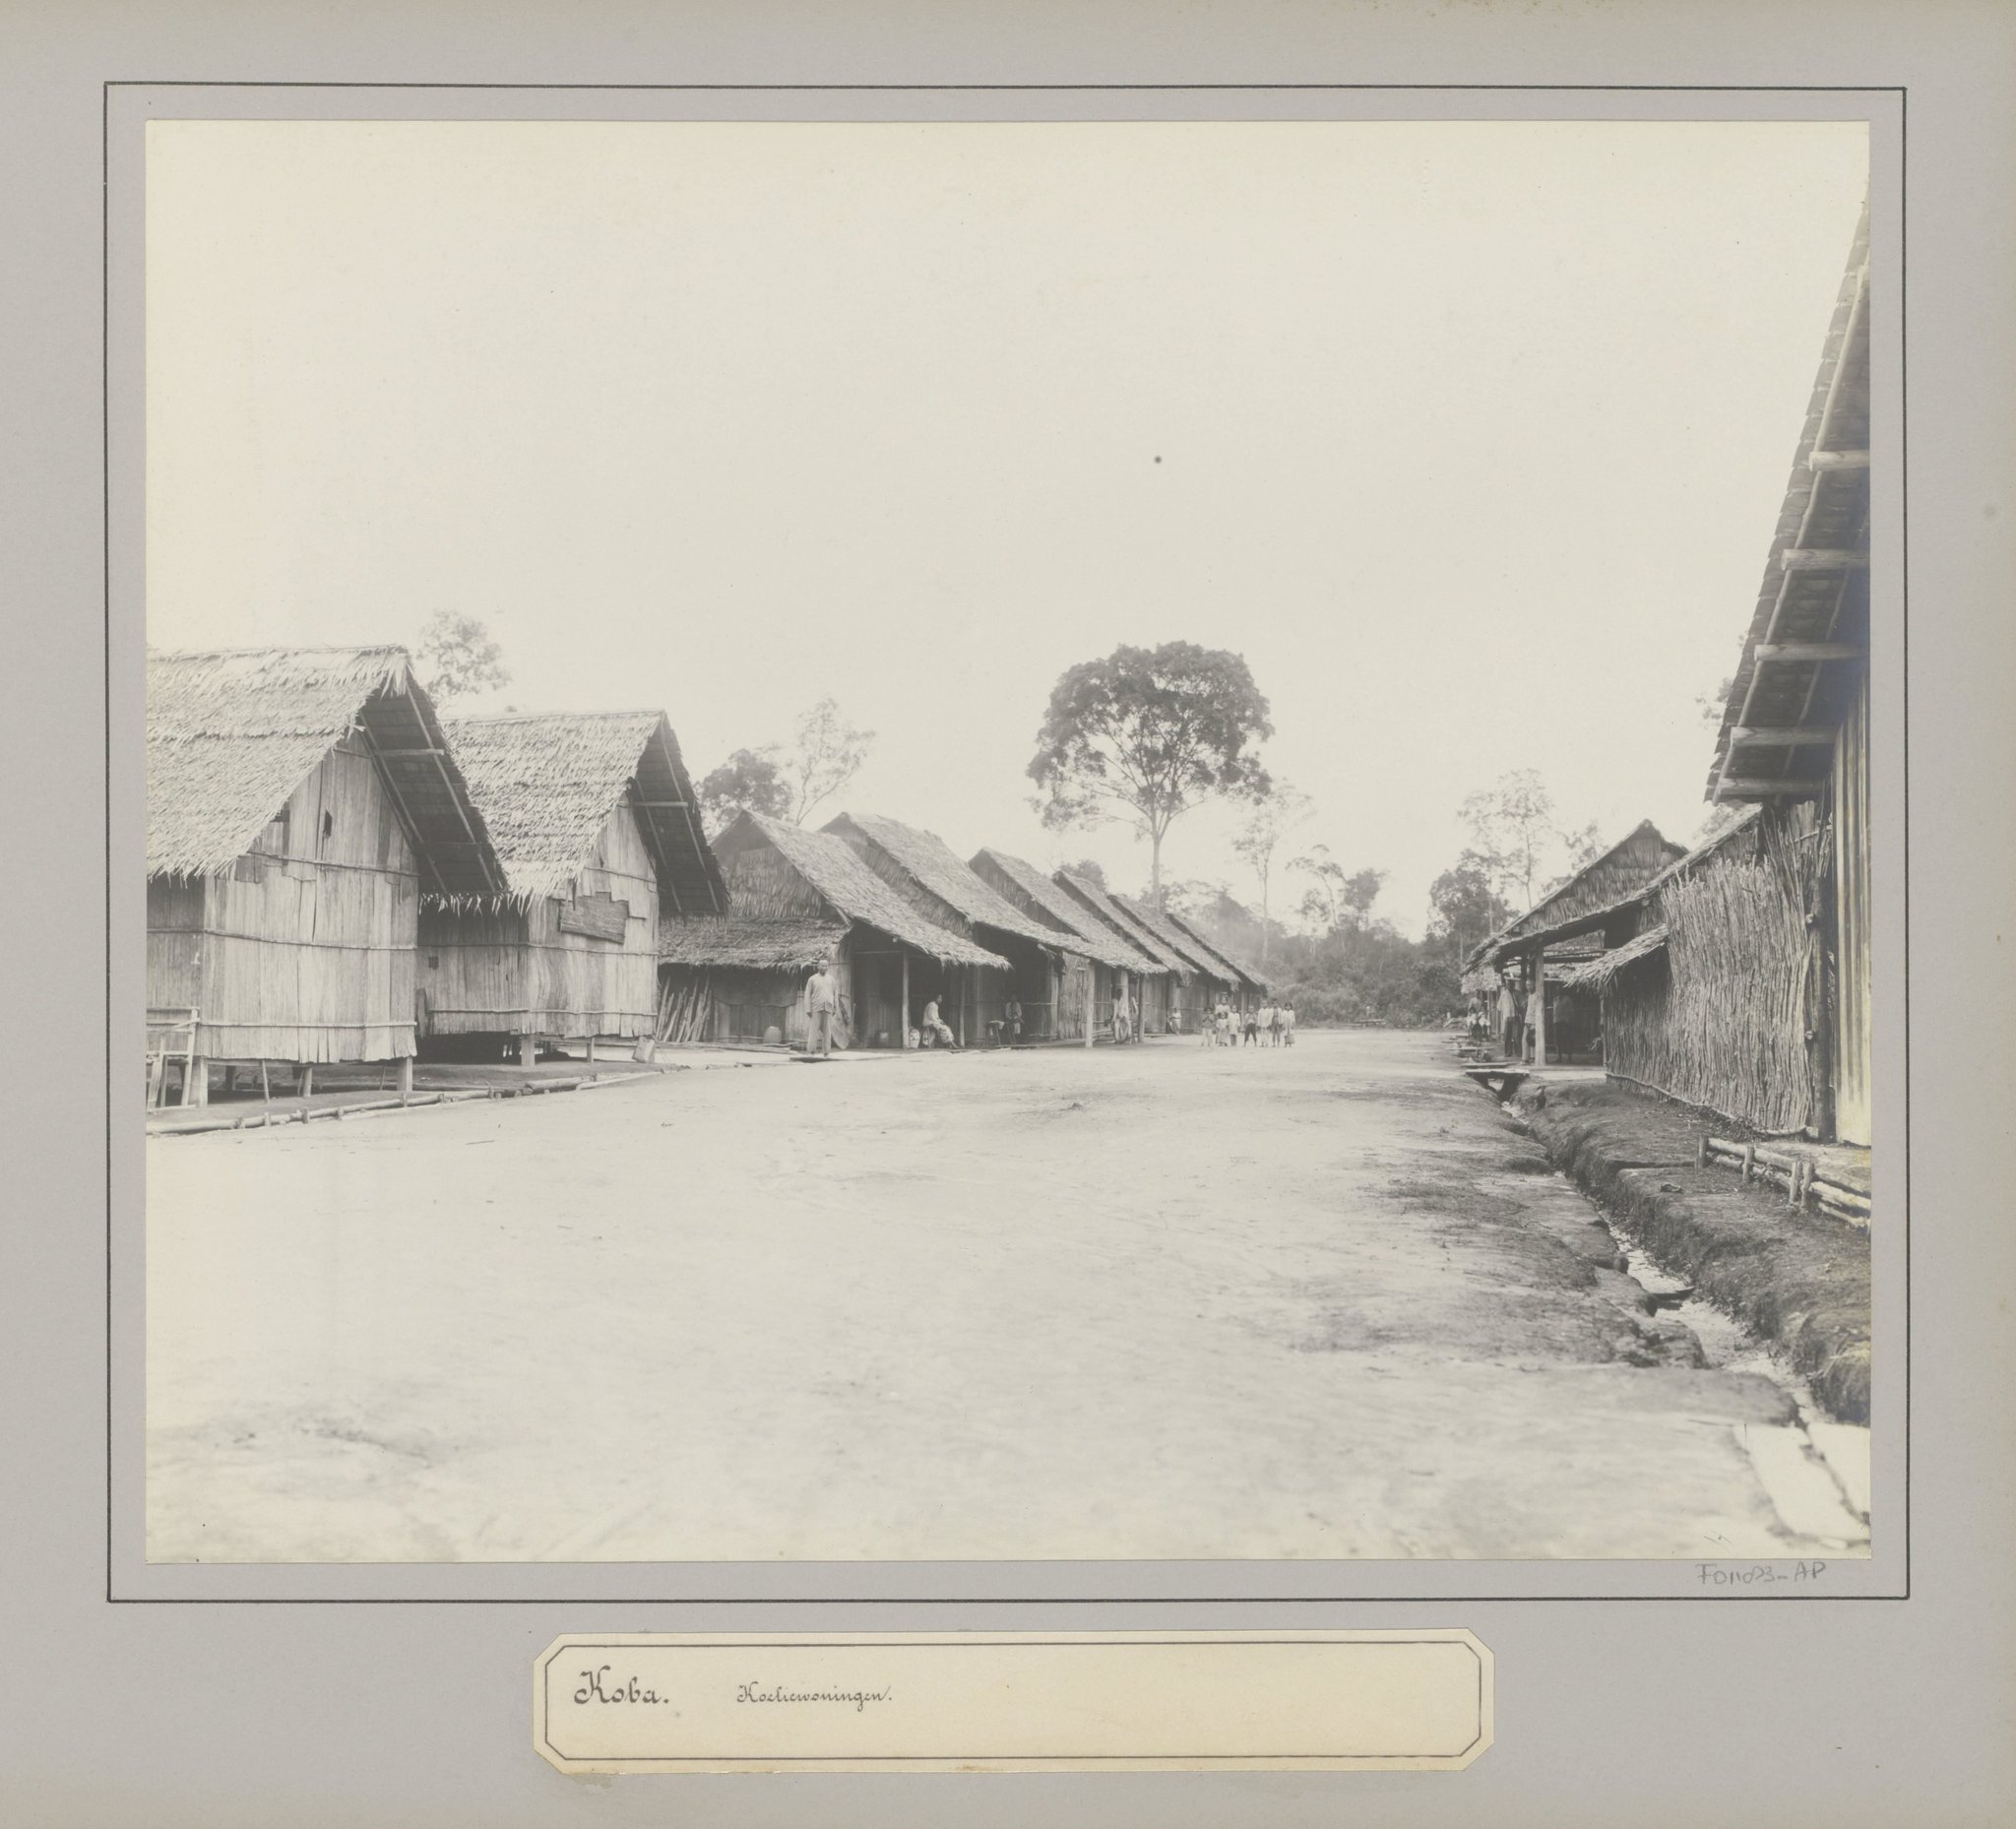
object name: photograph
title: Koba. Koeliewoningen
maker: Anonymous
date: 1900-1920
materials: photographic support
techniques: gelatin silver print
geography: koba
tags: mining, minerals and metals: tin, child, rural housing, e.g. country-house, villa, cottage, working class, labourers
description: Onderdeel van Fotoalbum over de tinwinning op Bangka.